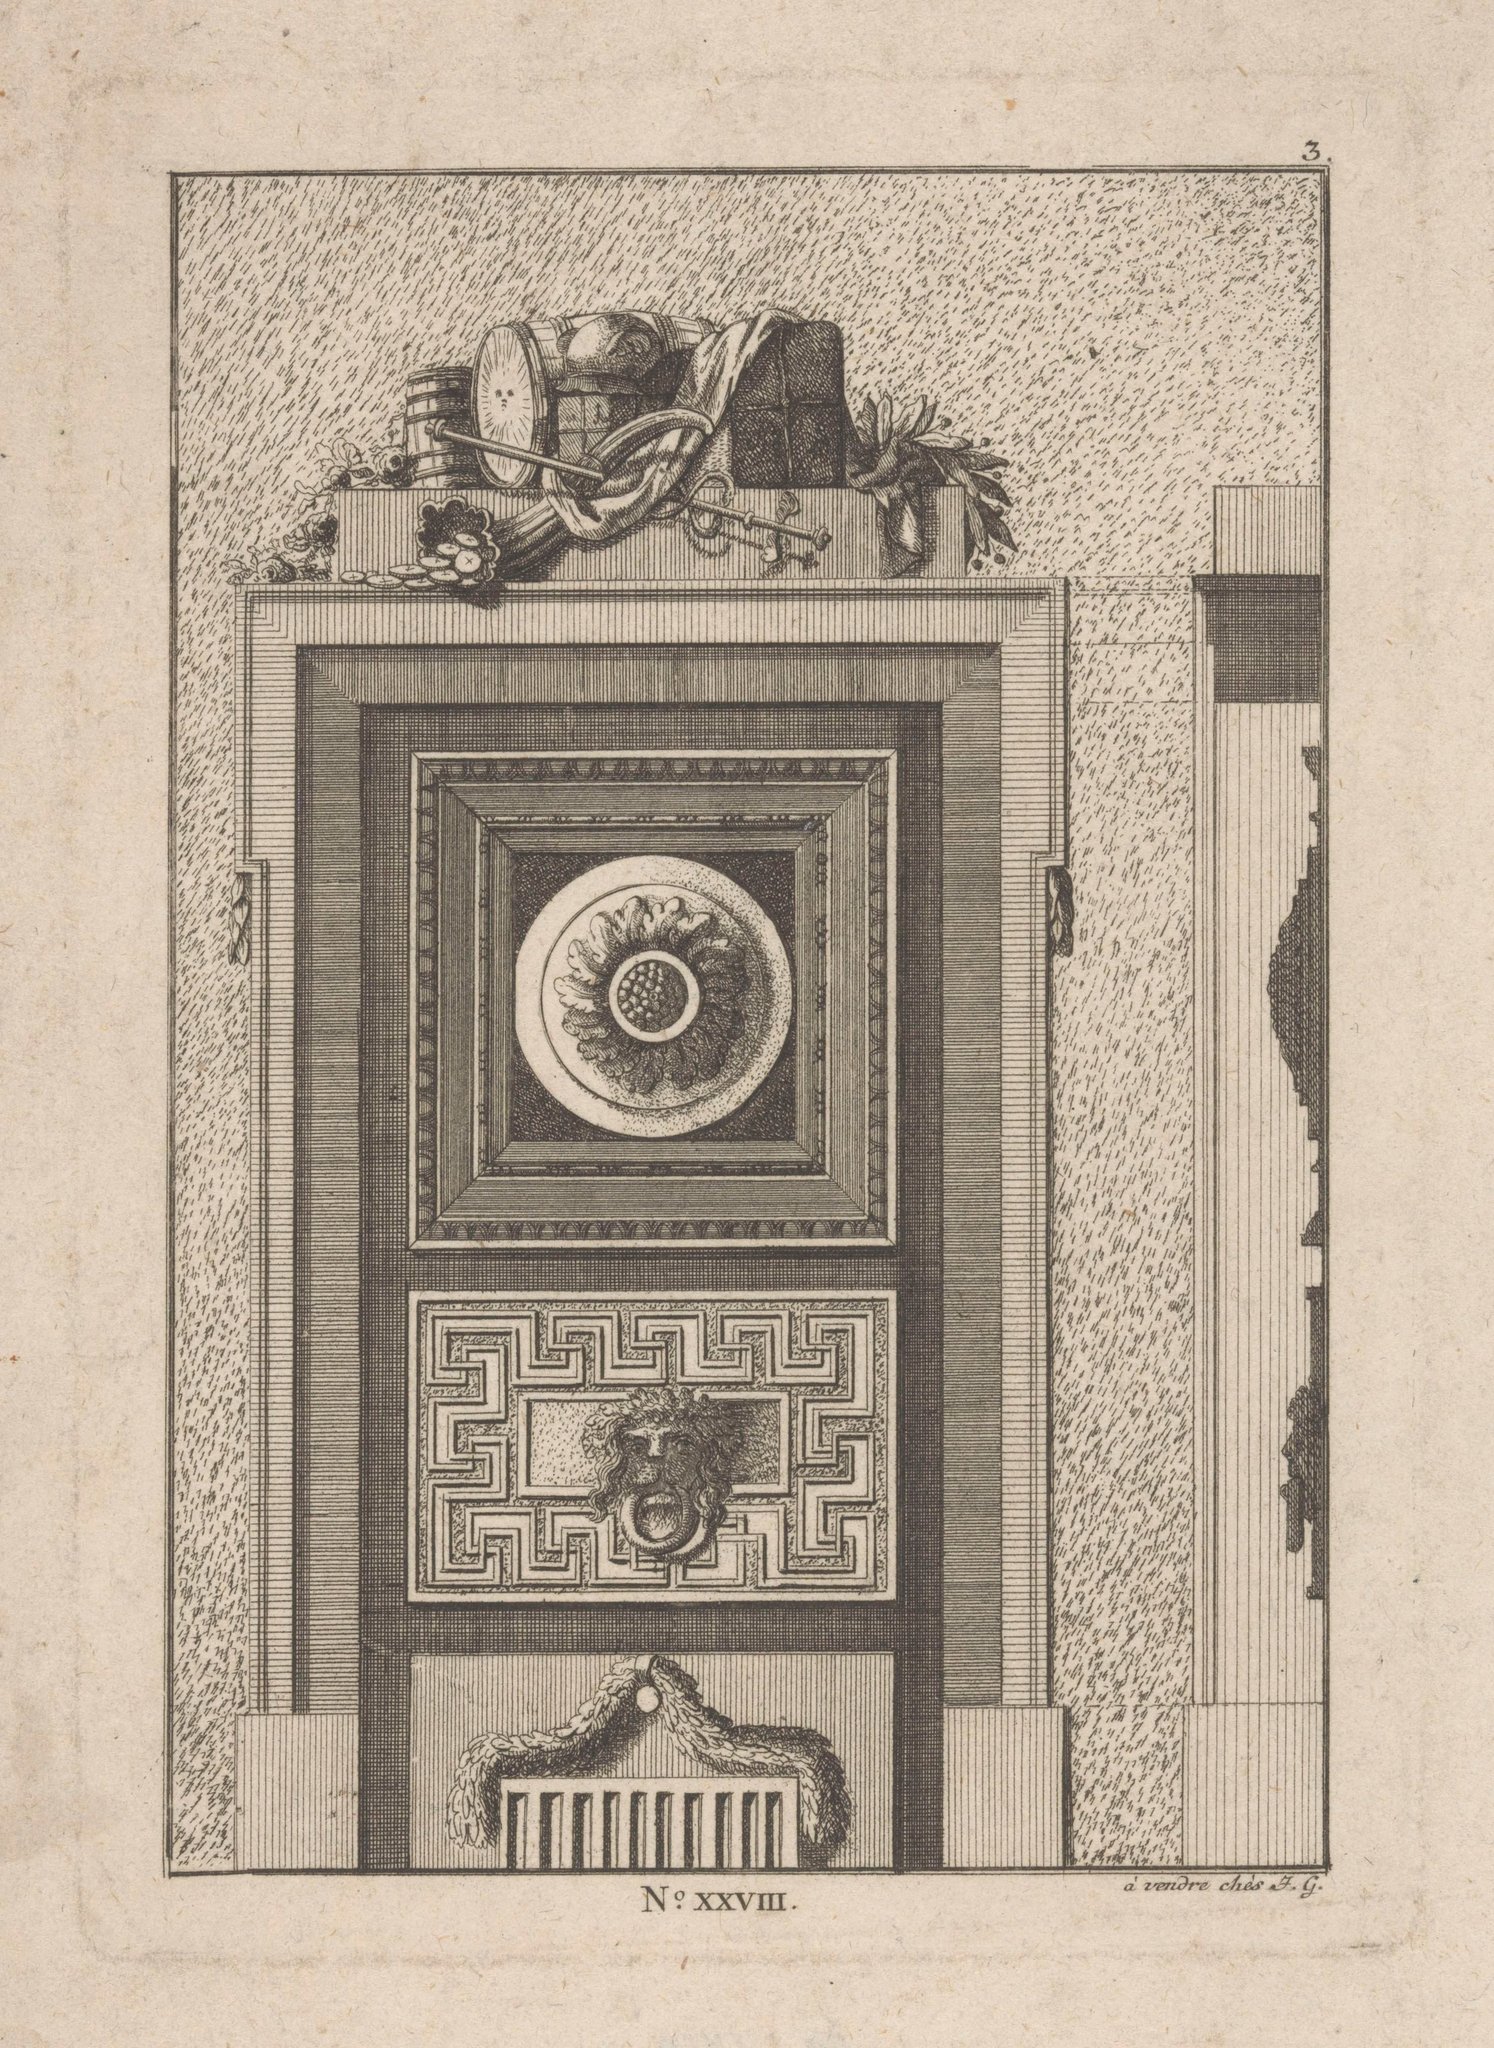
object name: ornament print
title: Muurgraven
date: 1779-1781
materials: paper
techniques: engraving, etching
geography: ravensburg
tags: niche-tomb, wall-tomb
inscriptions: collector's mark: Lugt 2760, collector's mark: Lugt 2228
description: Ontwerp en zijaanzicht van een muurgraf met geornamenteerde panelen en deurklopper in vorm van een kop. Bovenop gedecoreerd met vaten, de hoorn des overvloeds en Mercuriusstaf en -helm. Uitgeversnummer XXVIII.